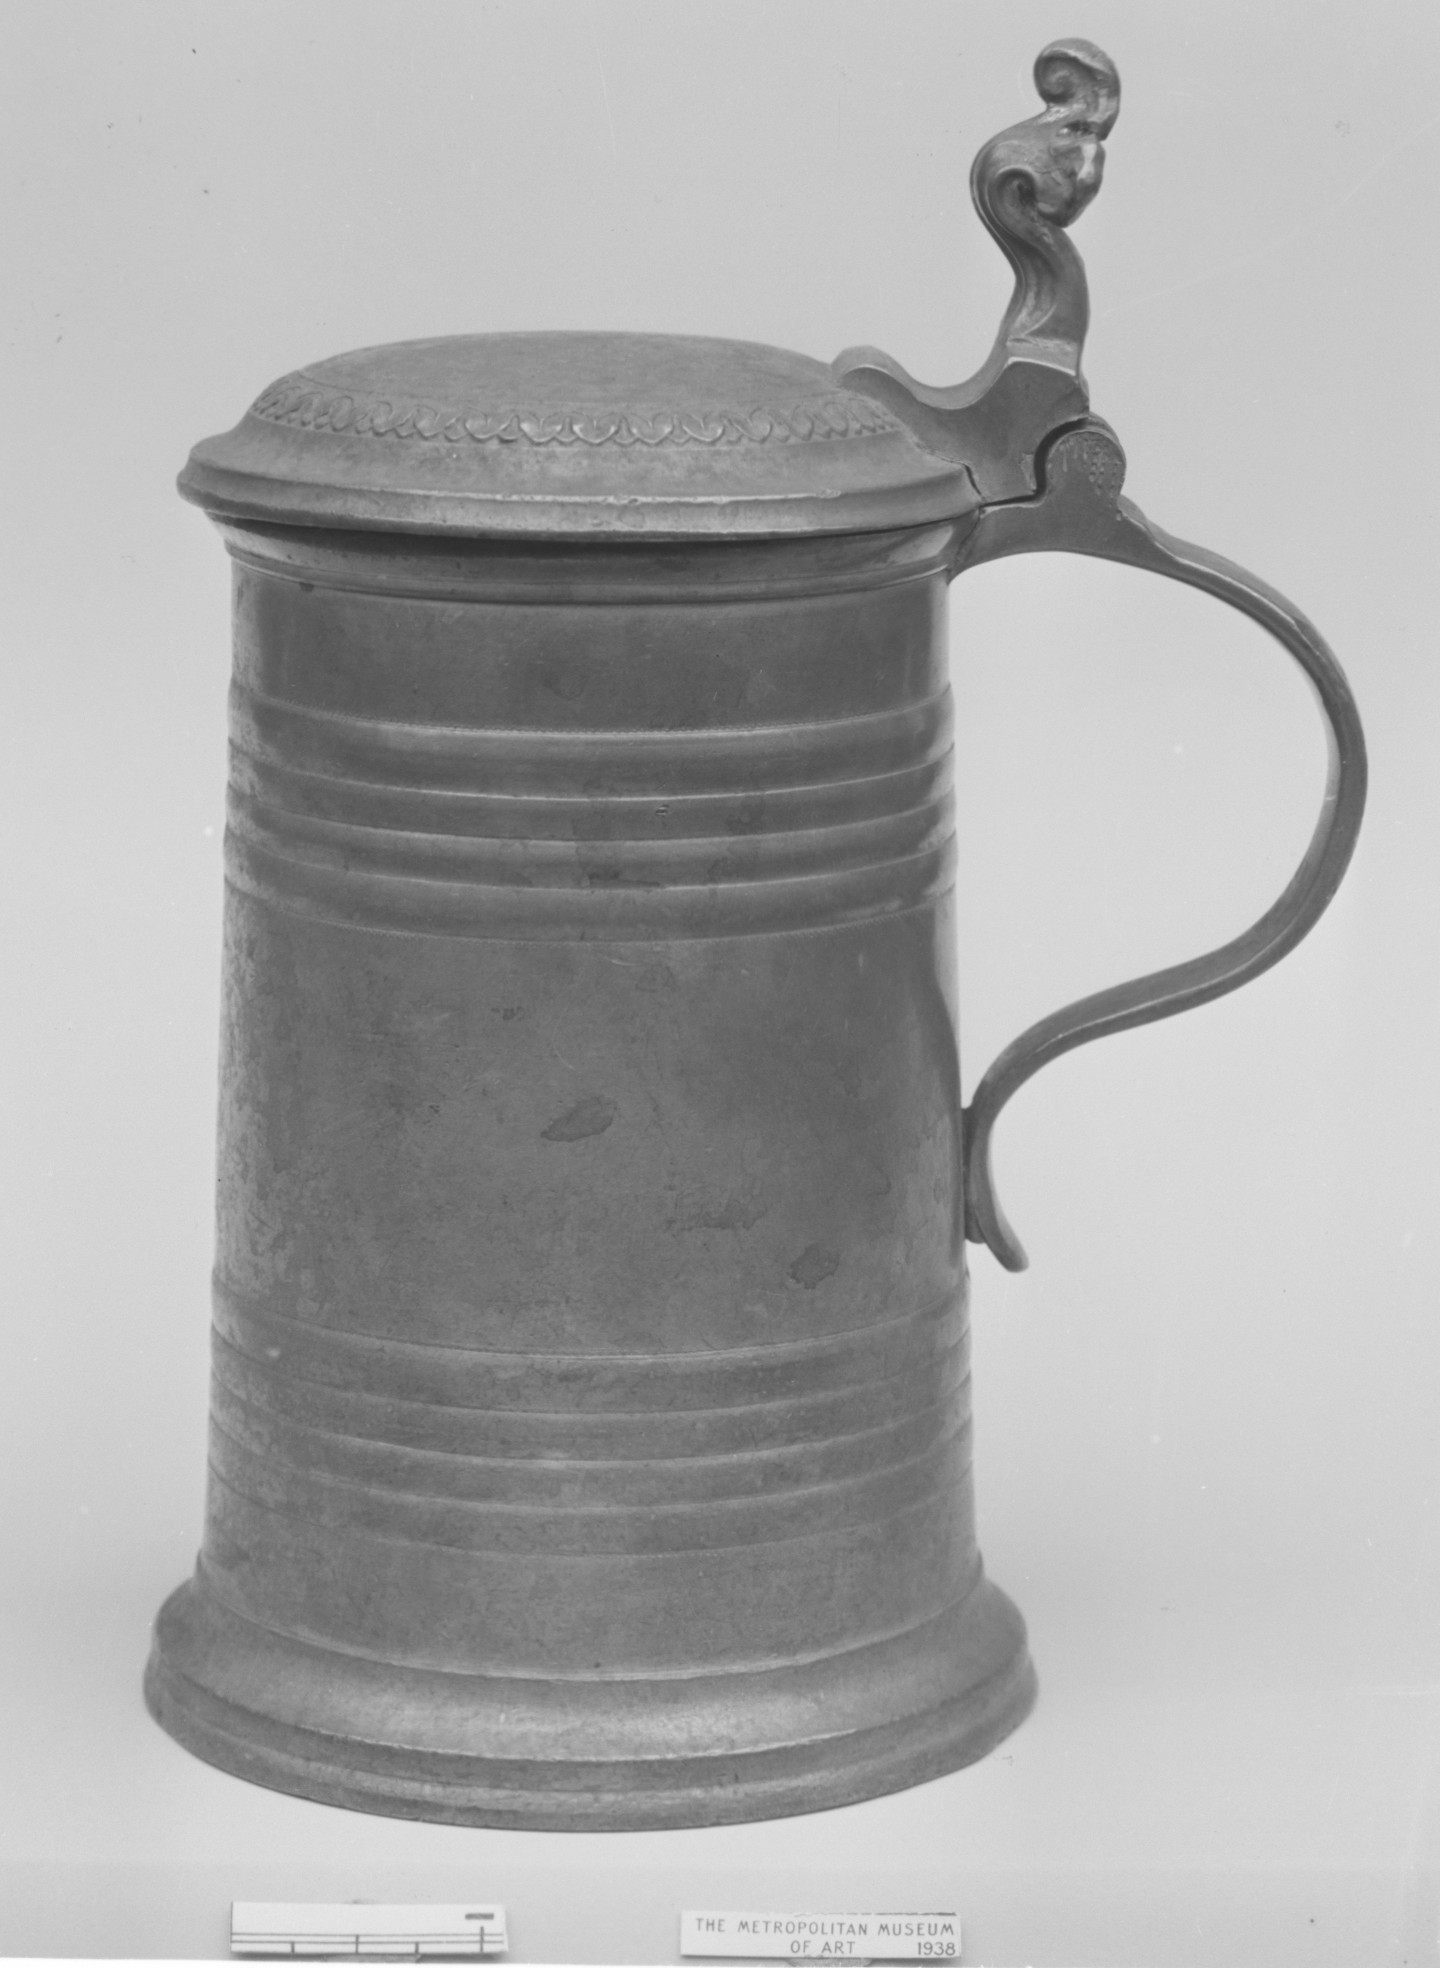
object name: tankard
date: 1801-1900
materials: pewter